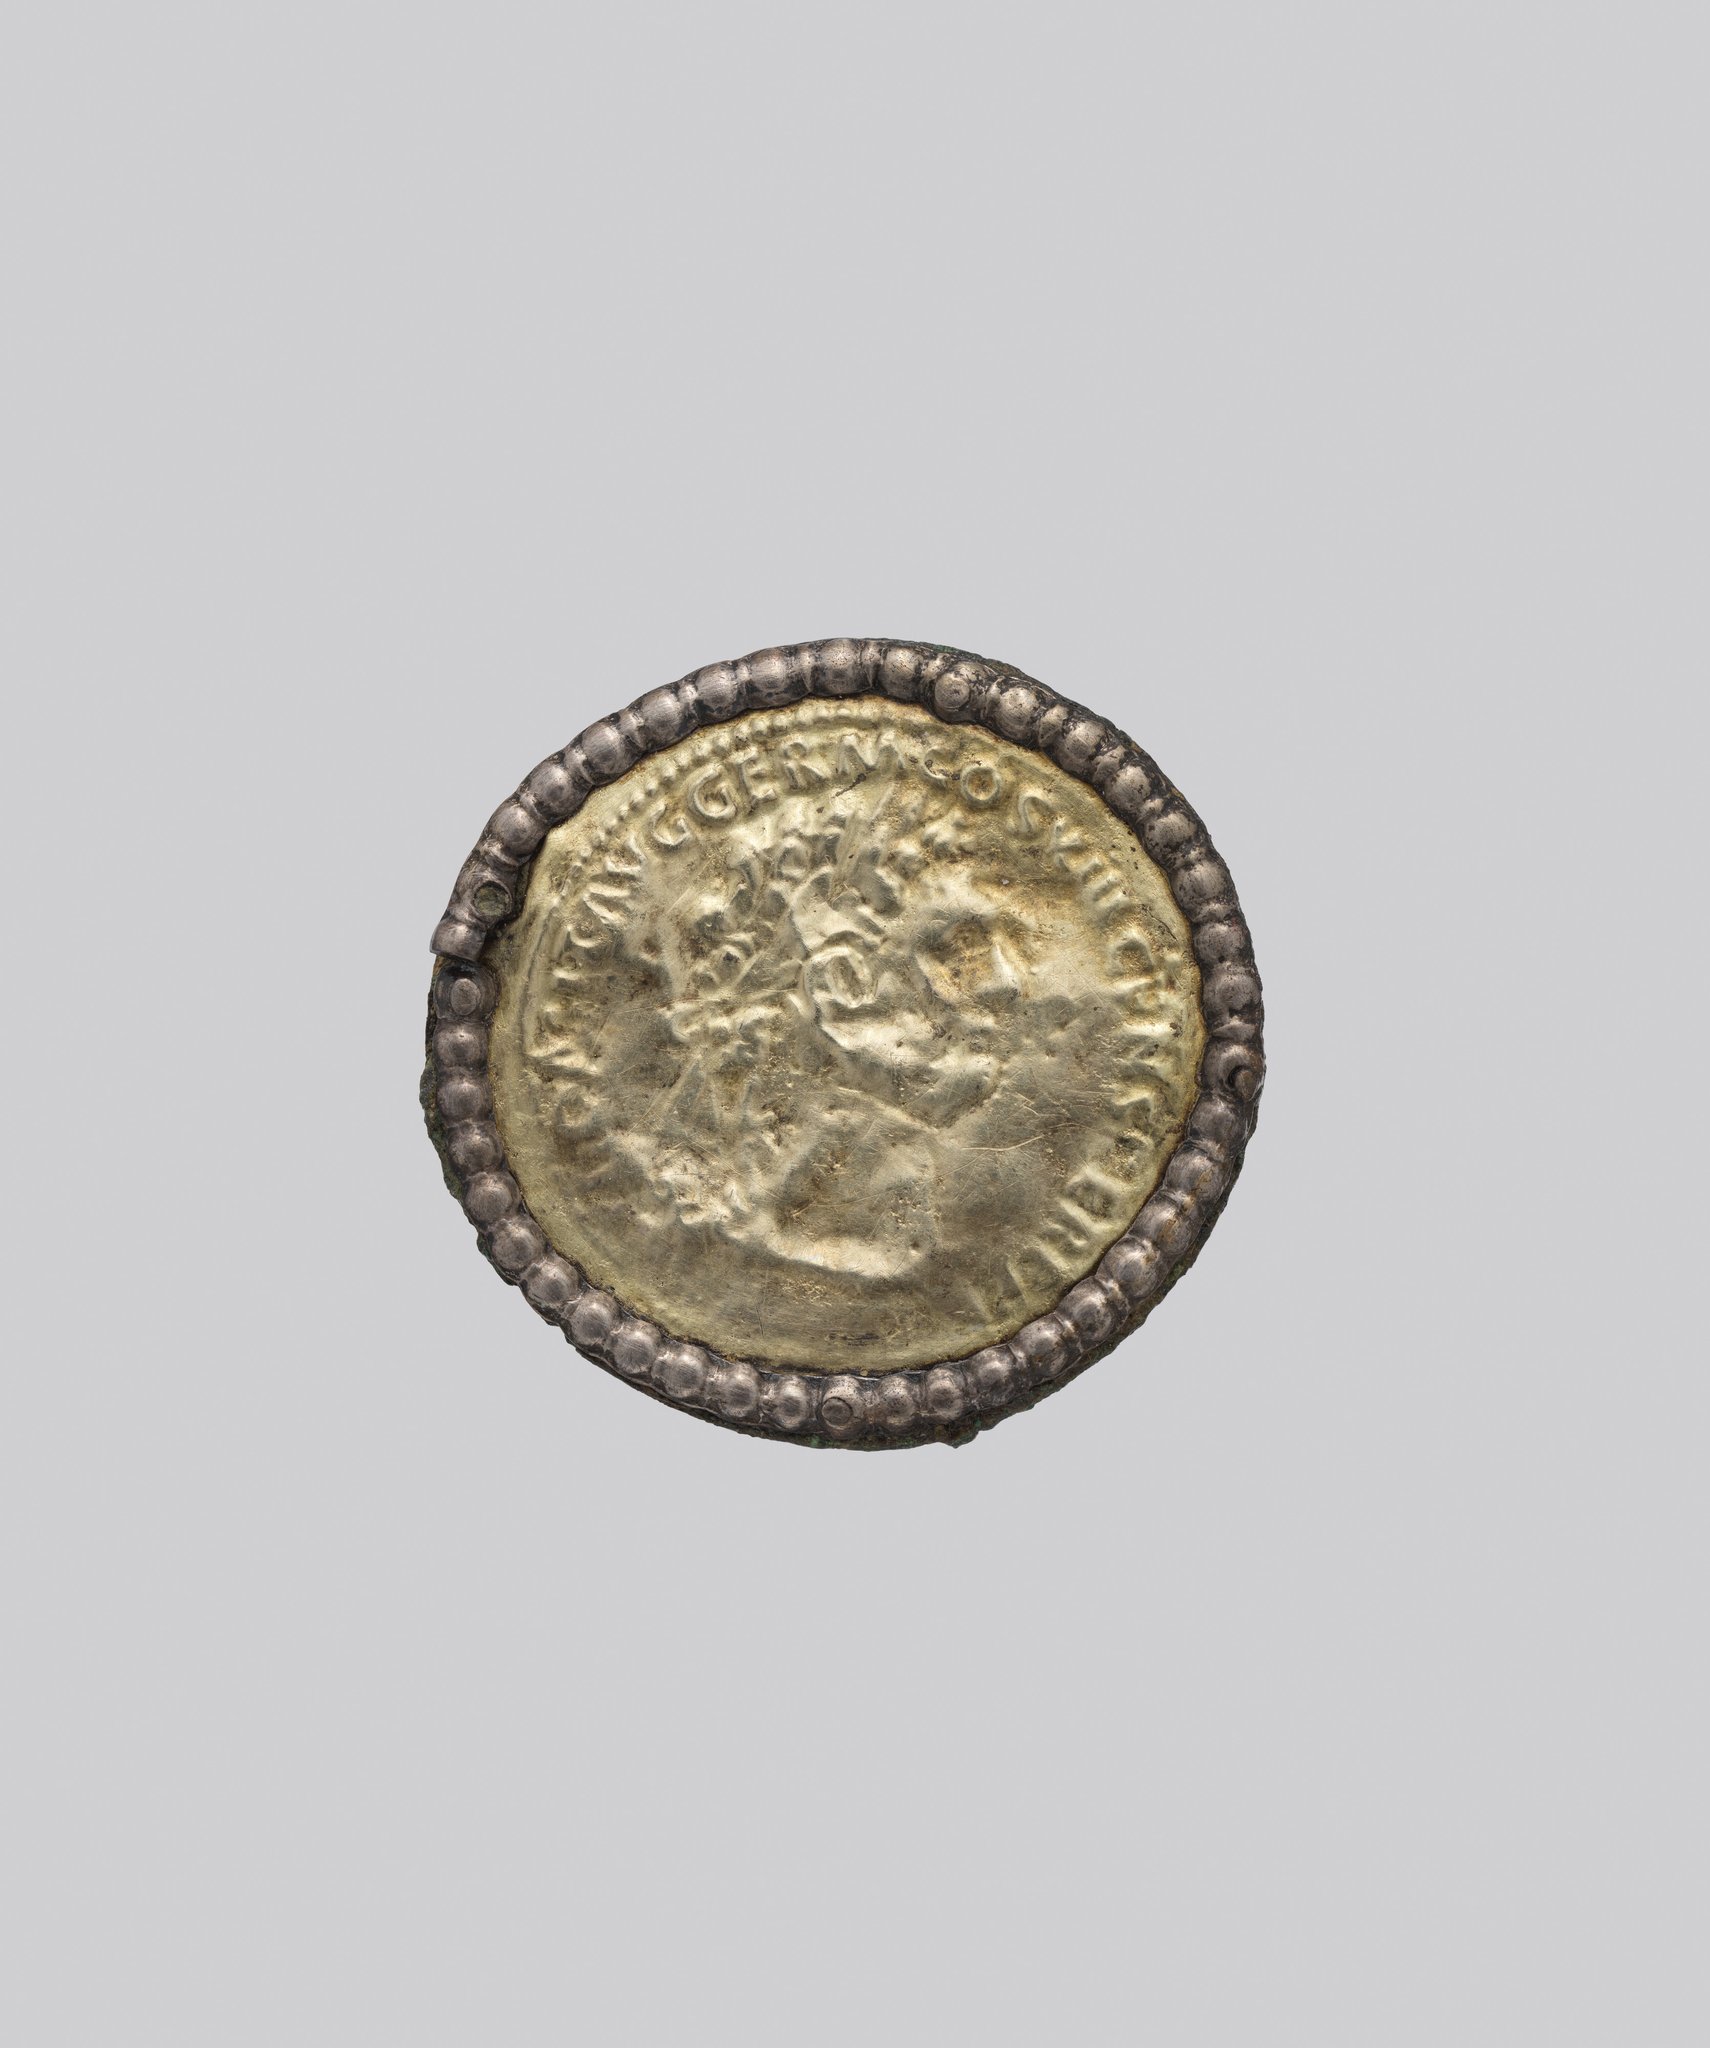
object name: brooch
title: Gold Disk Brooch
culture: frankish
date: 501-700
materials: bronze, iron, silver gilt